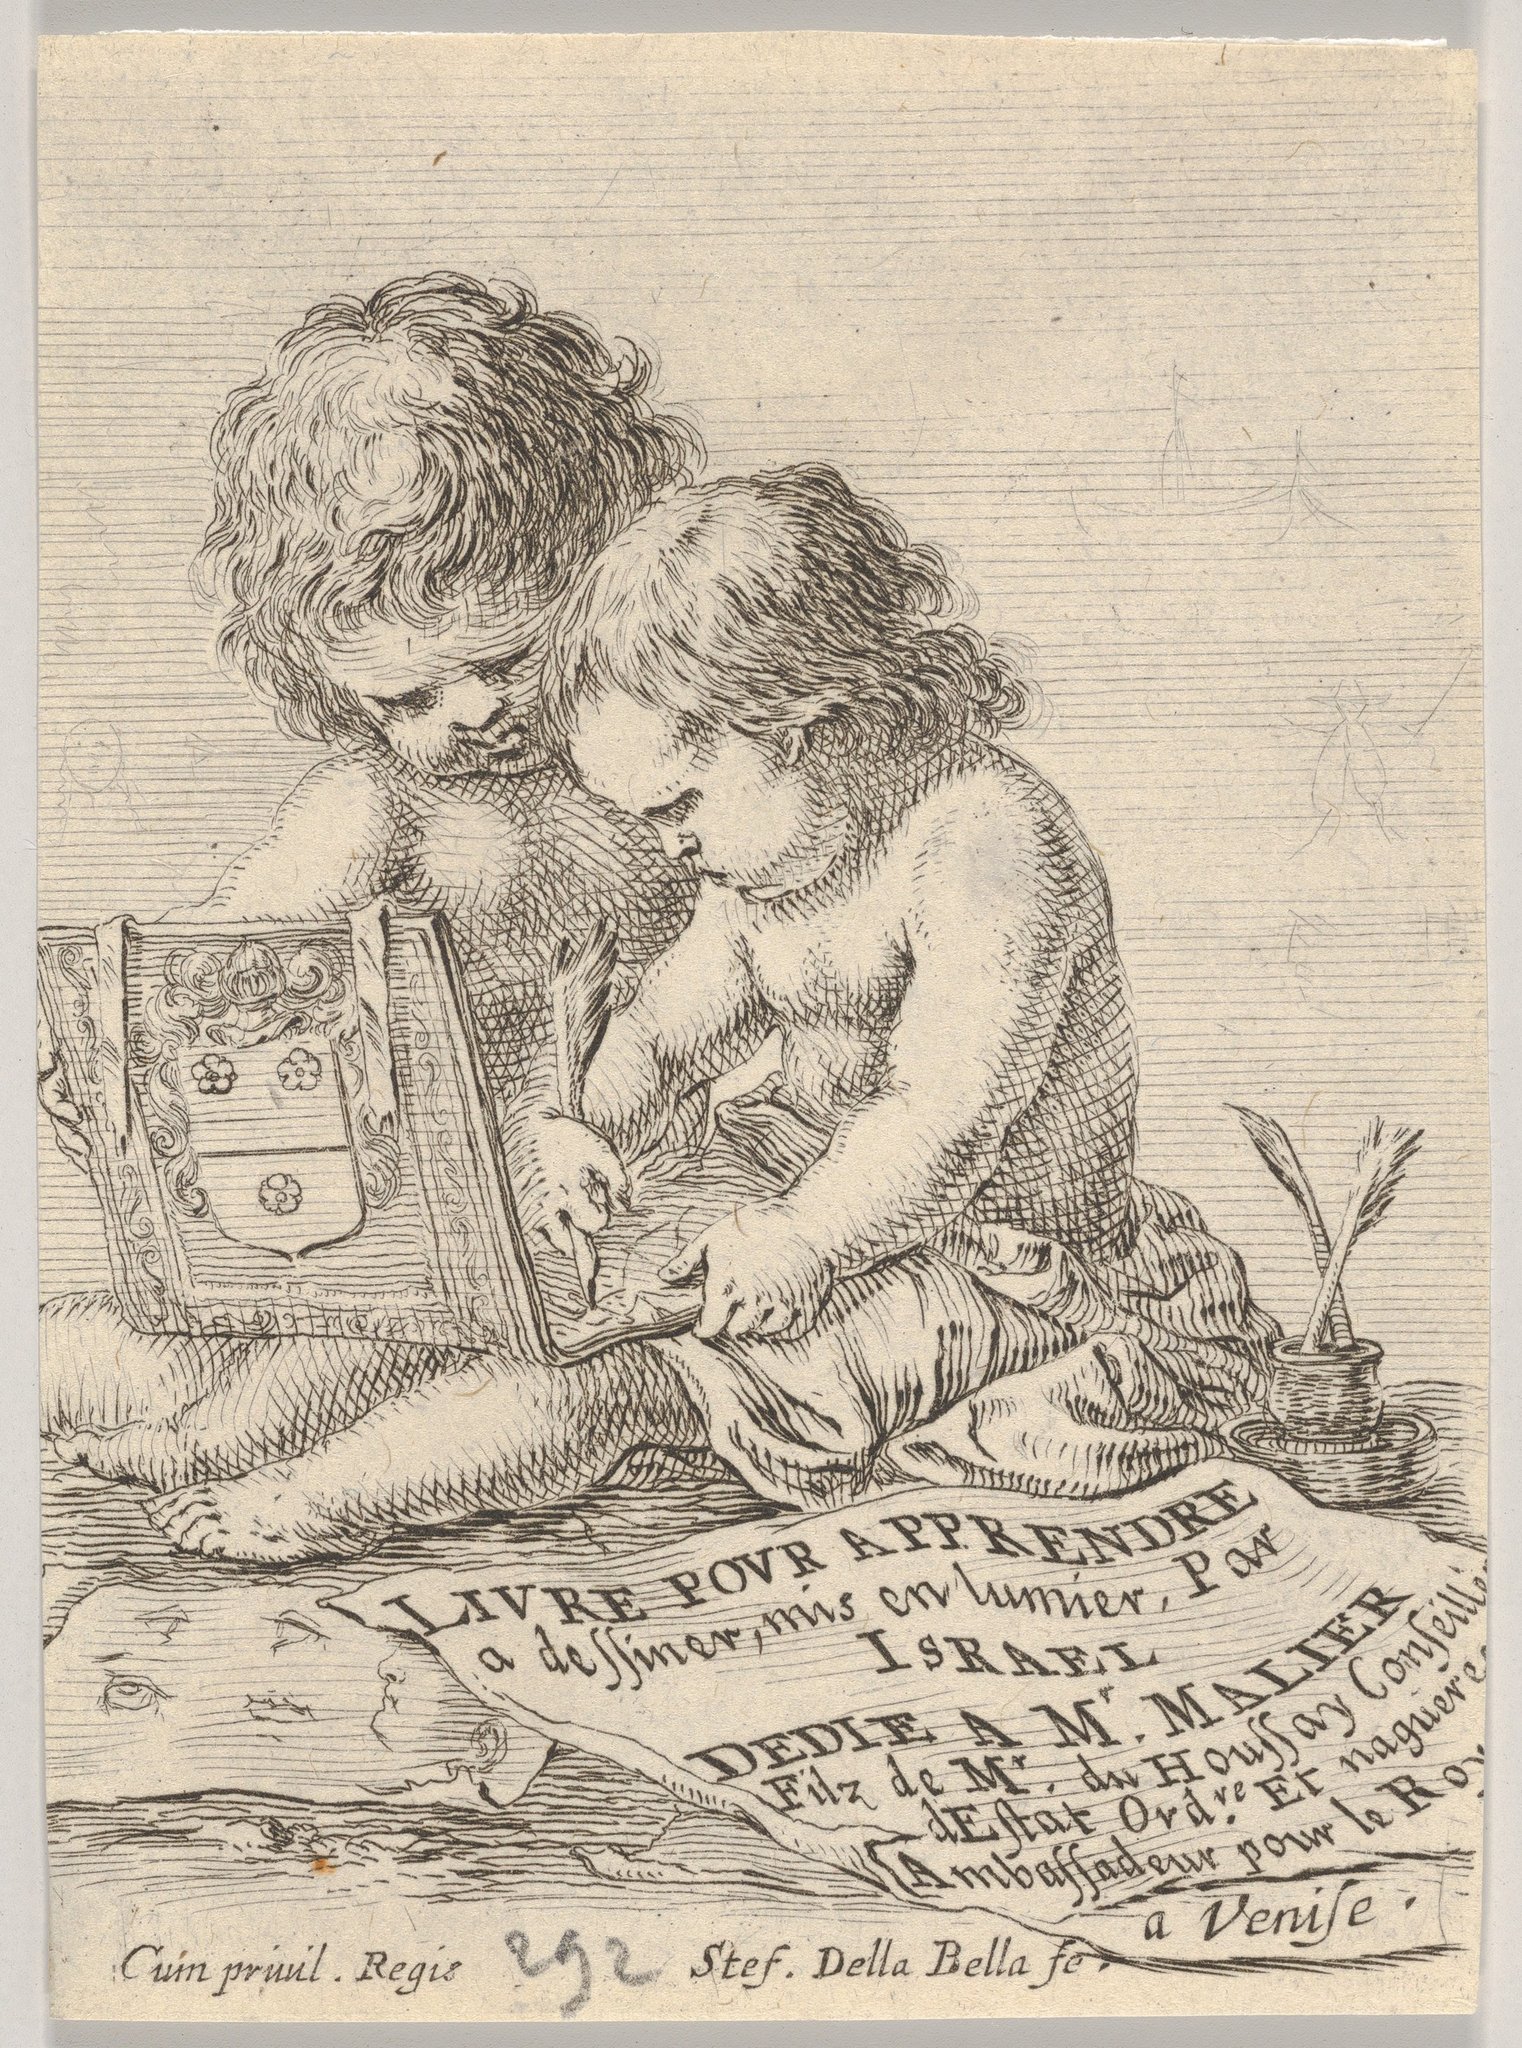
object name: print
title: Plate 1: Two children sitting on the ground, the child on the right drawing while the child on the left holding the album, title page from "The Book for Learning to Draw" (Livre pour apprendre à dessiner)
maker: stefano della bella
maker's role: artist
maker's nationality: italian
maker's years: 1610-1664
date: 1649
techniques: etching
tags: drawing,children